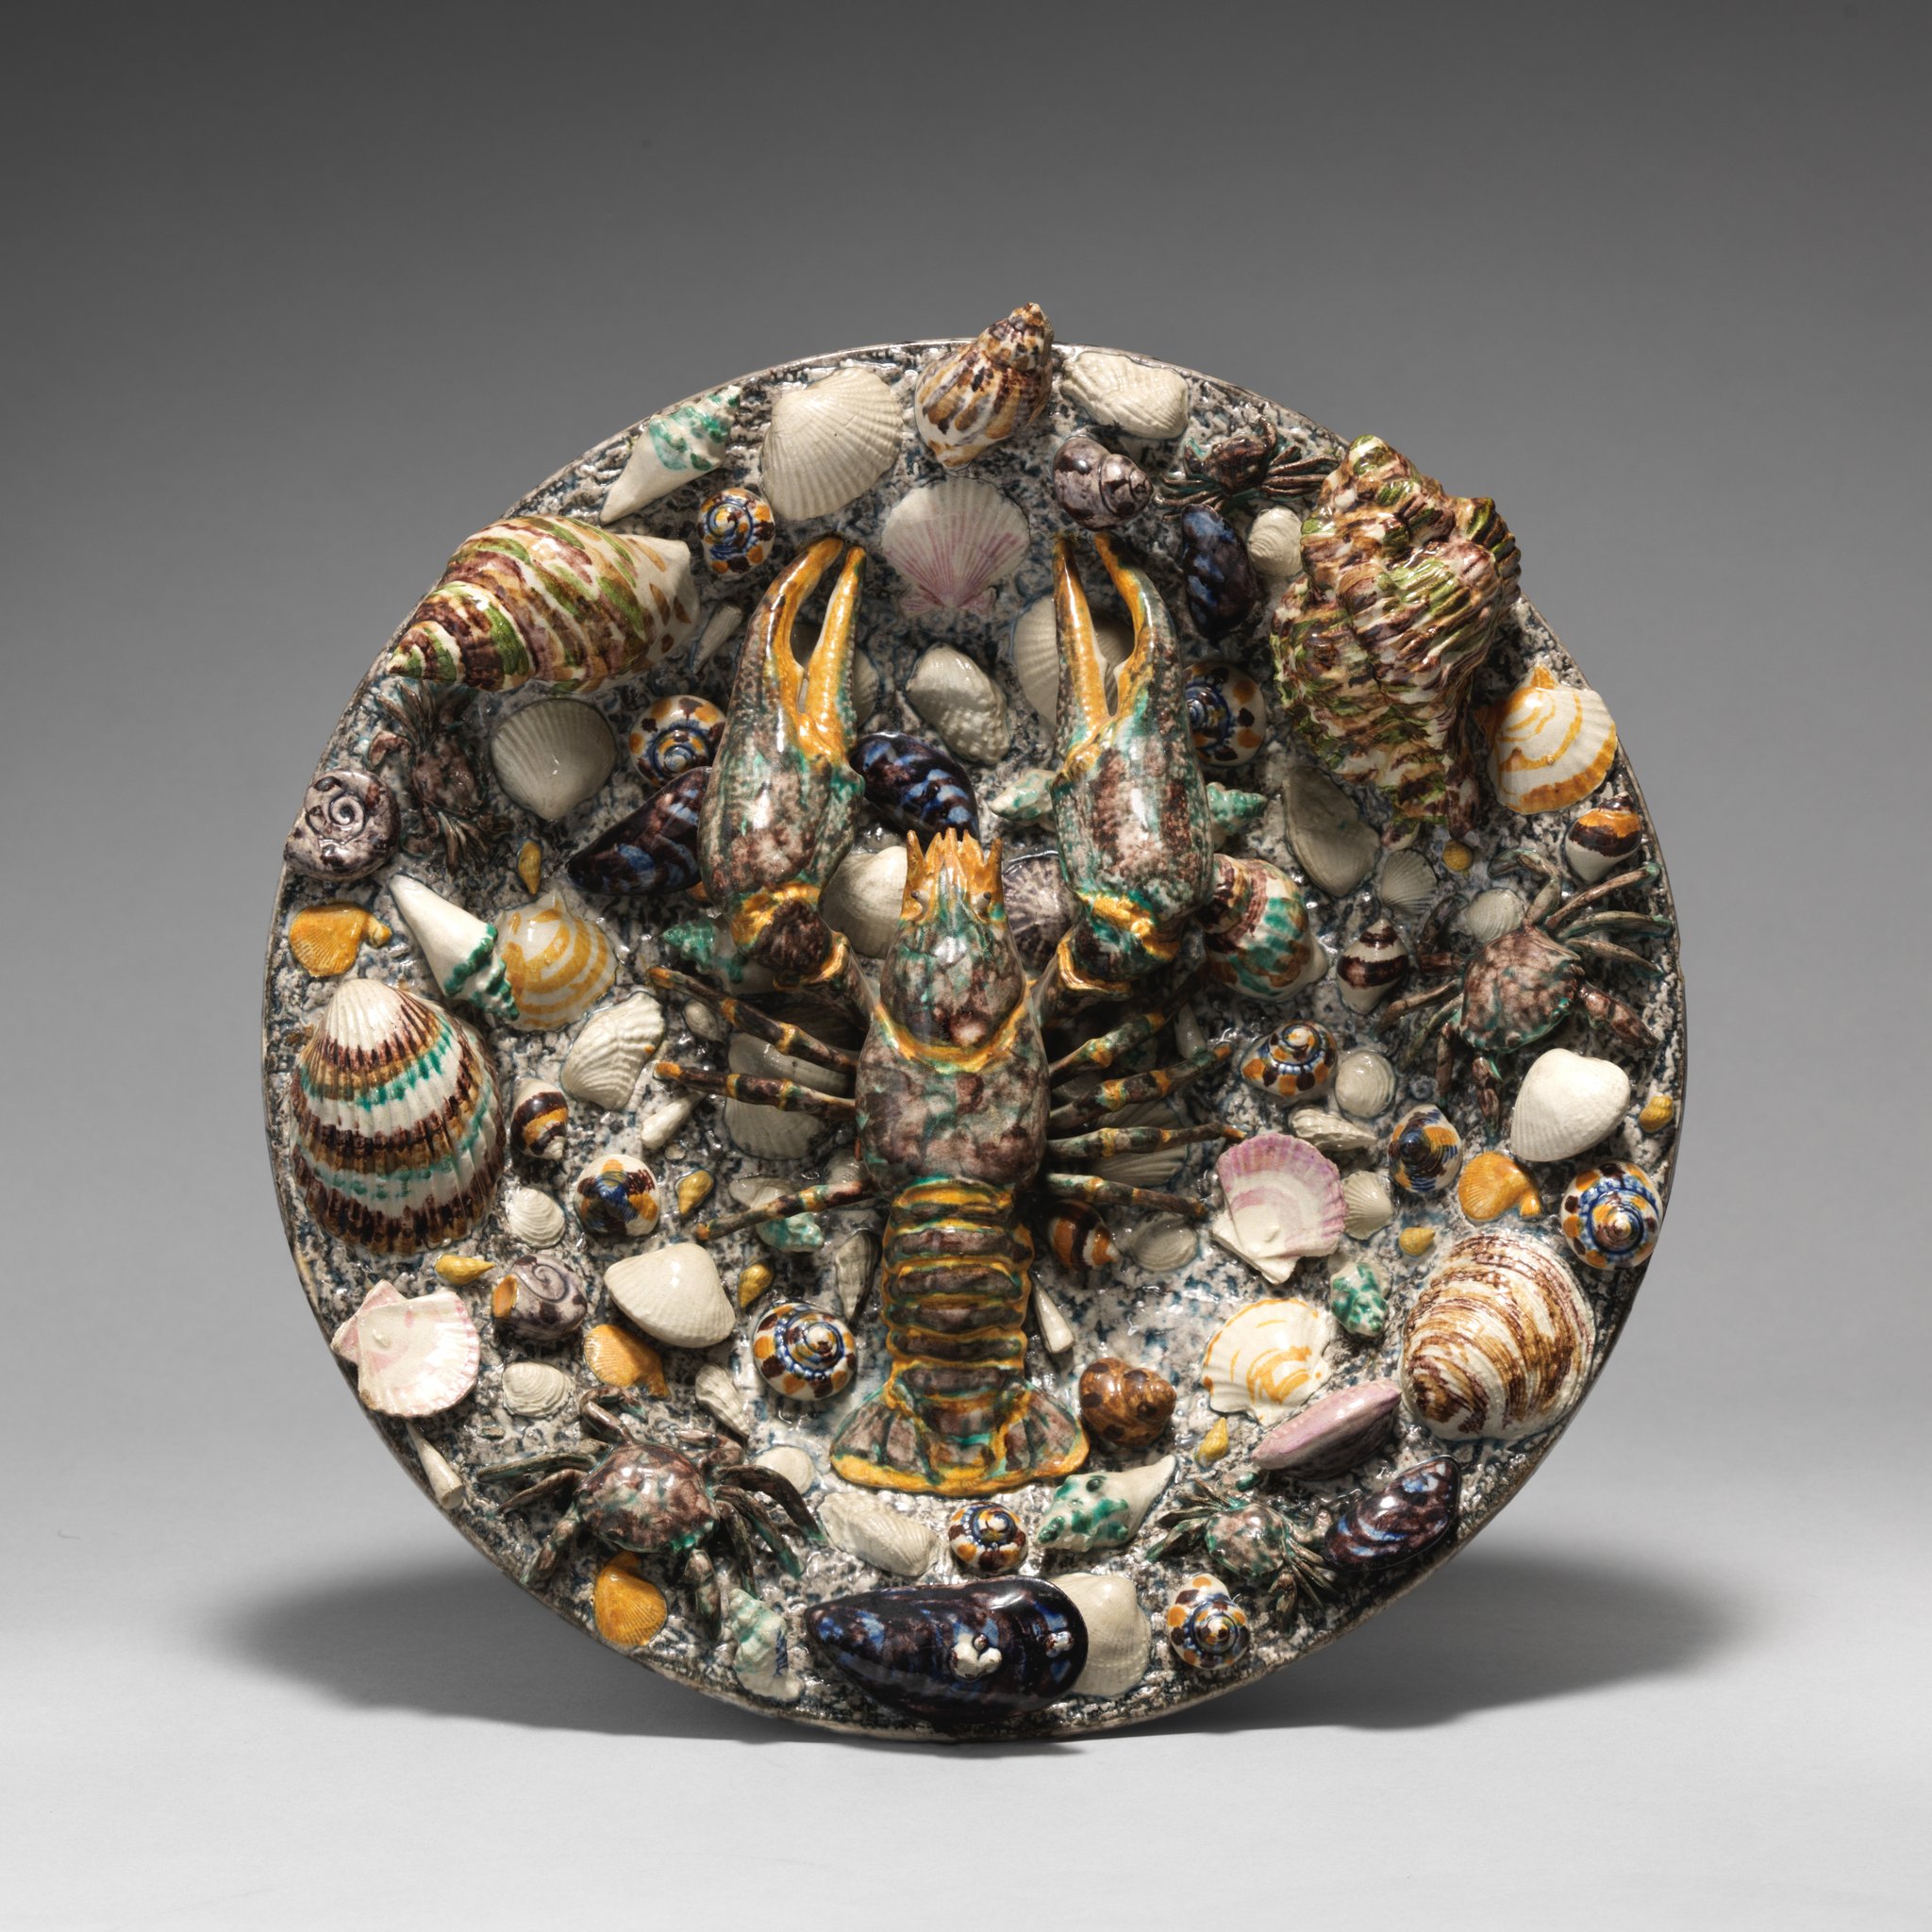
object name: dish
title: Round dish with lobster and shells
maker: thomas-victor sergent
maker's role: maker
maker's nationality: french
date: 1870-1880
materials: earthenware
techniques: glazing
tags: lobsters,shells